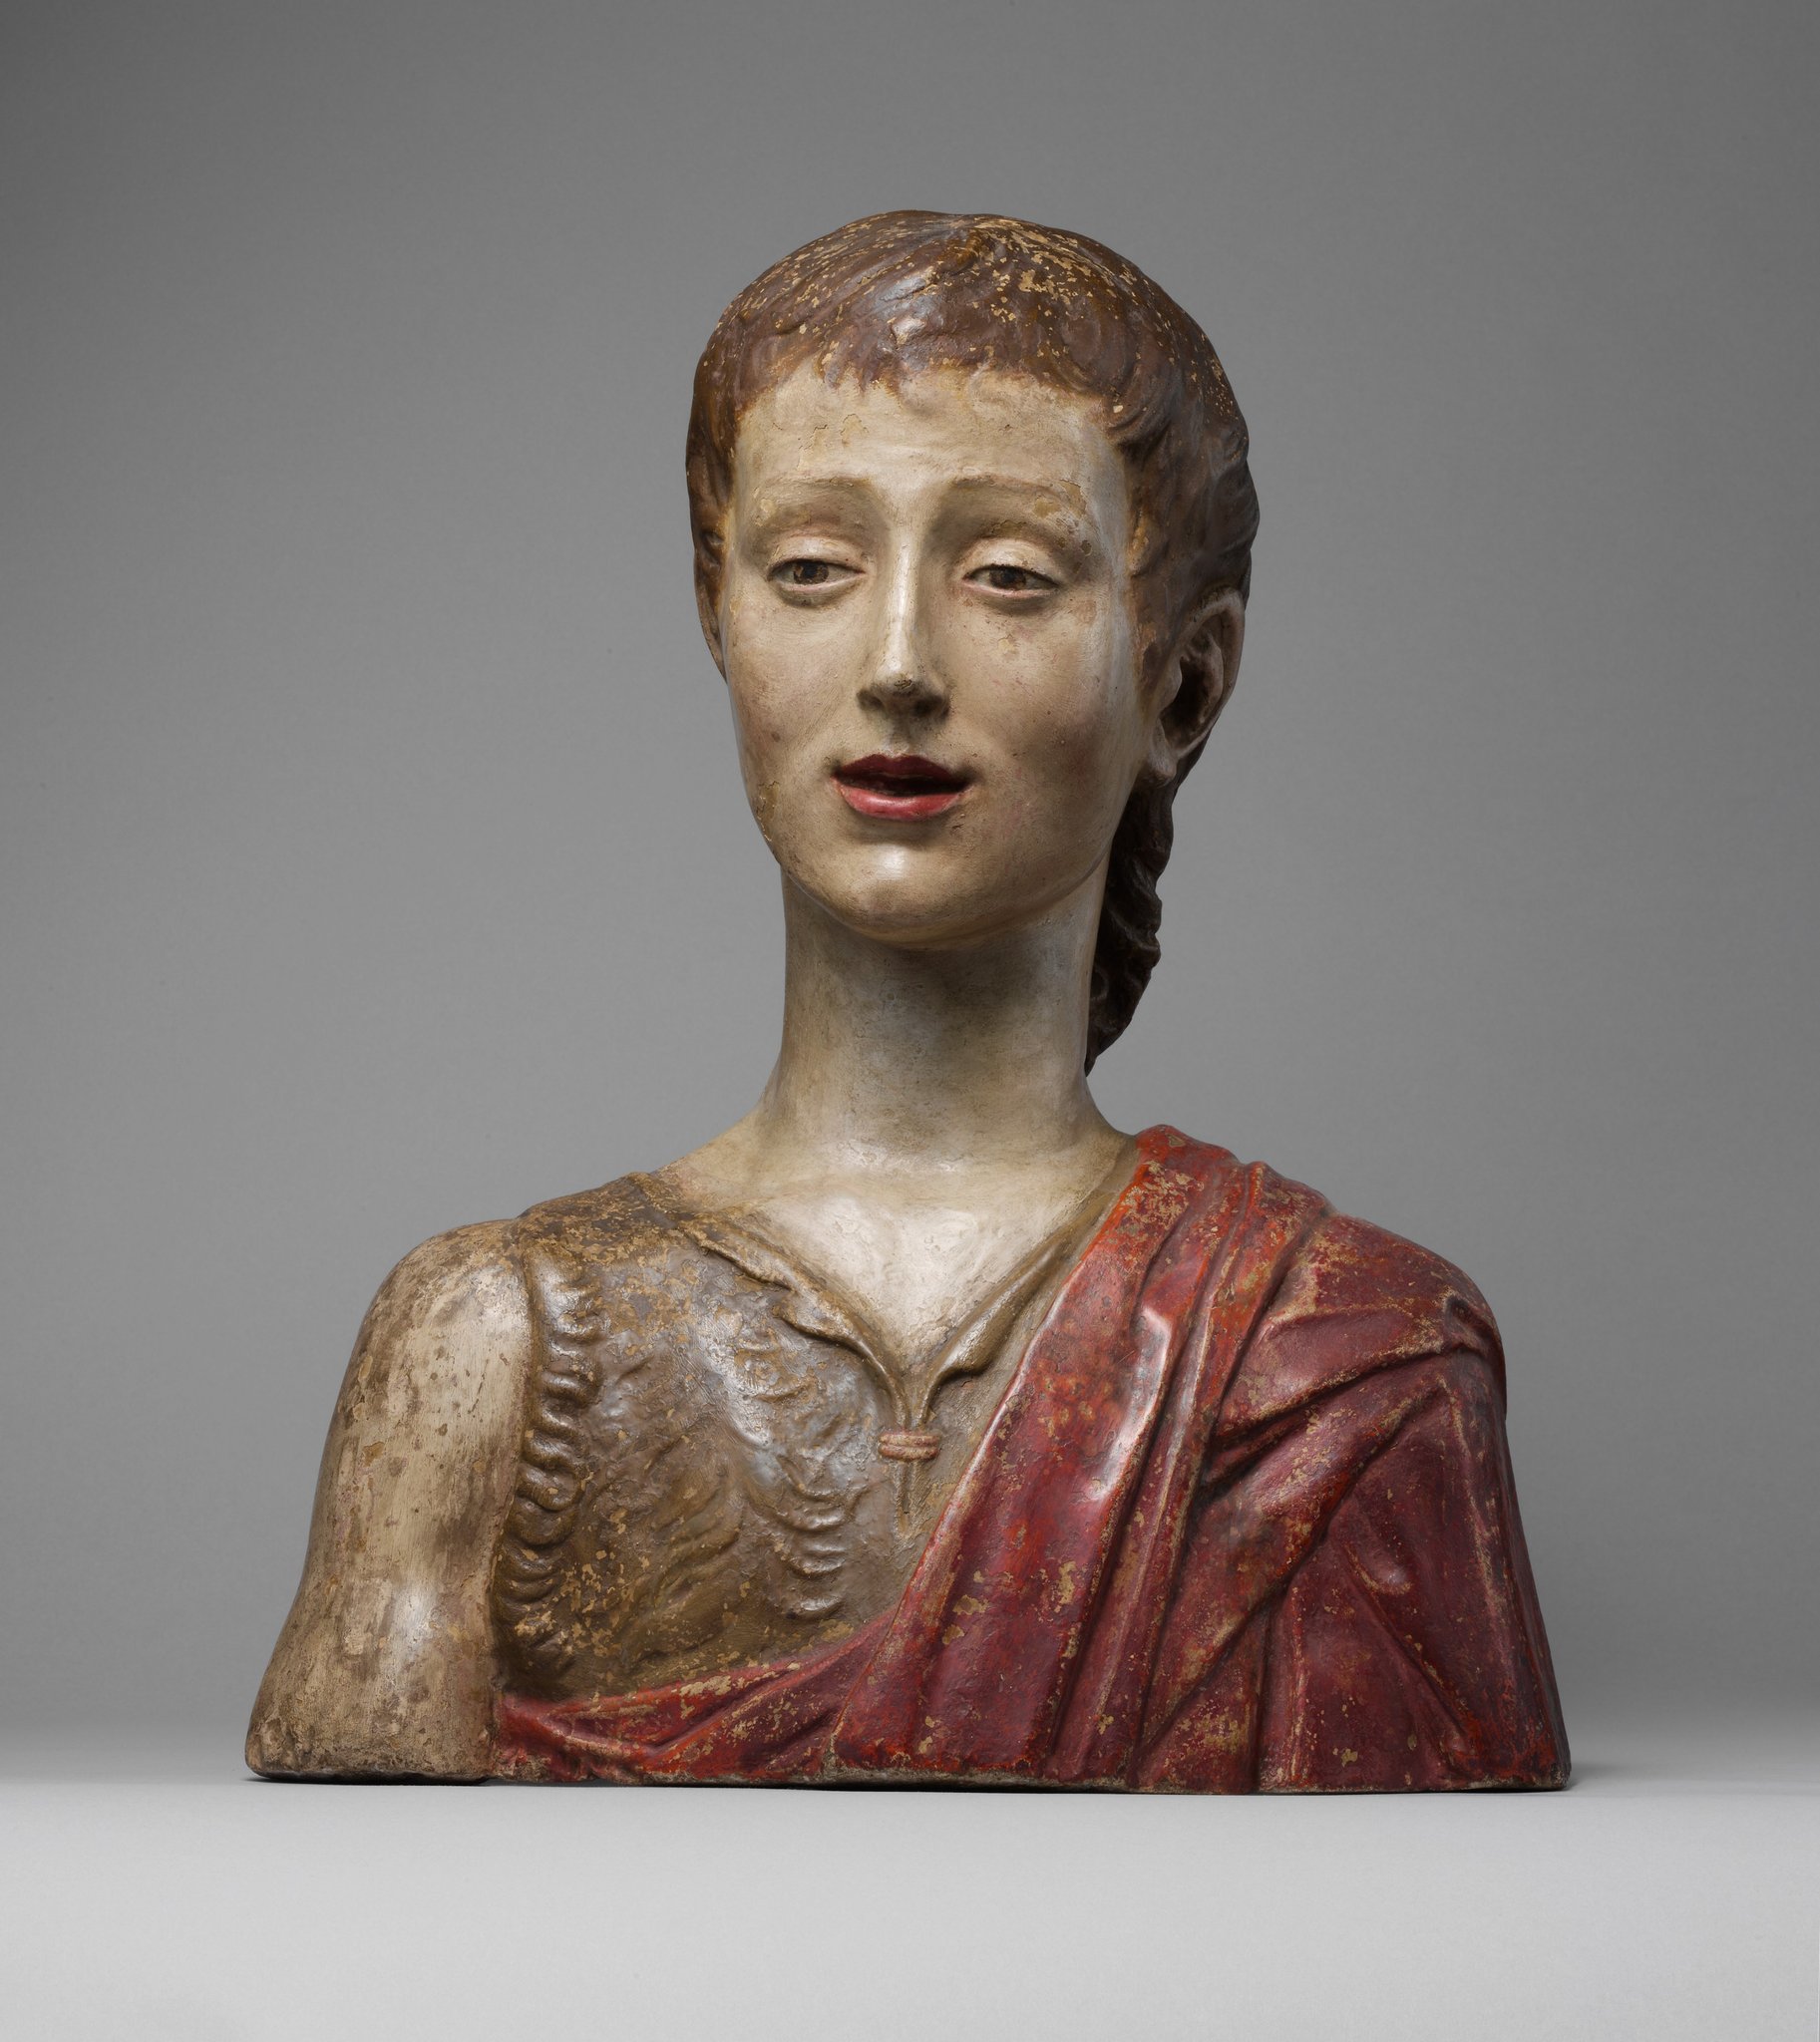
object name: bust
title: Saint John the Baptist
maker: mino da fiesole (mino di giovanni)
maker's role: artist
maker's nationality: italian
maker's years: 1429-1484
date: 1476-1500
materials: gilt, plaster, wood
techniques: polychrome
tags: saint john the baptist